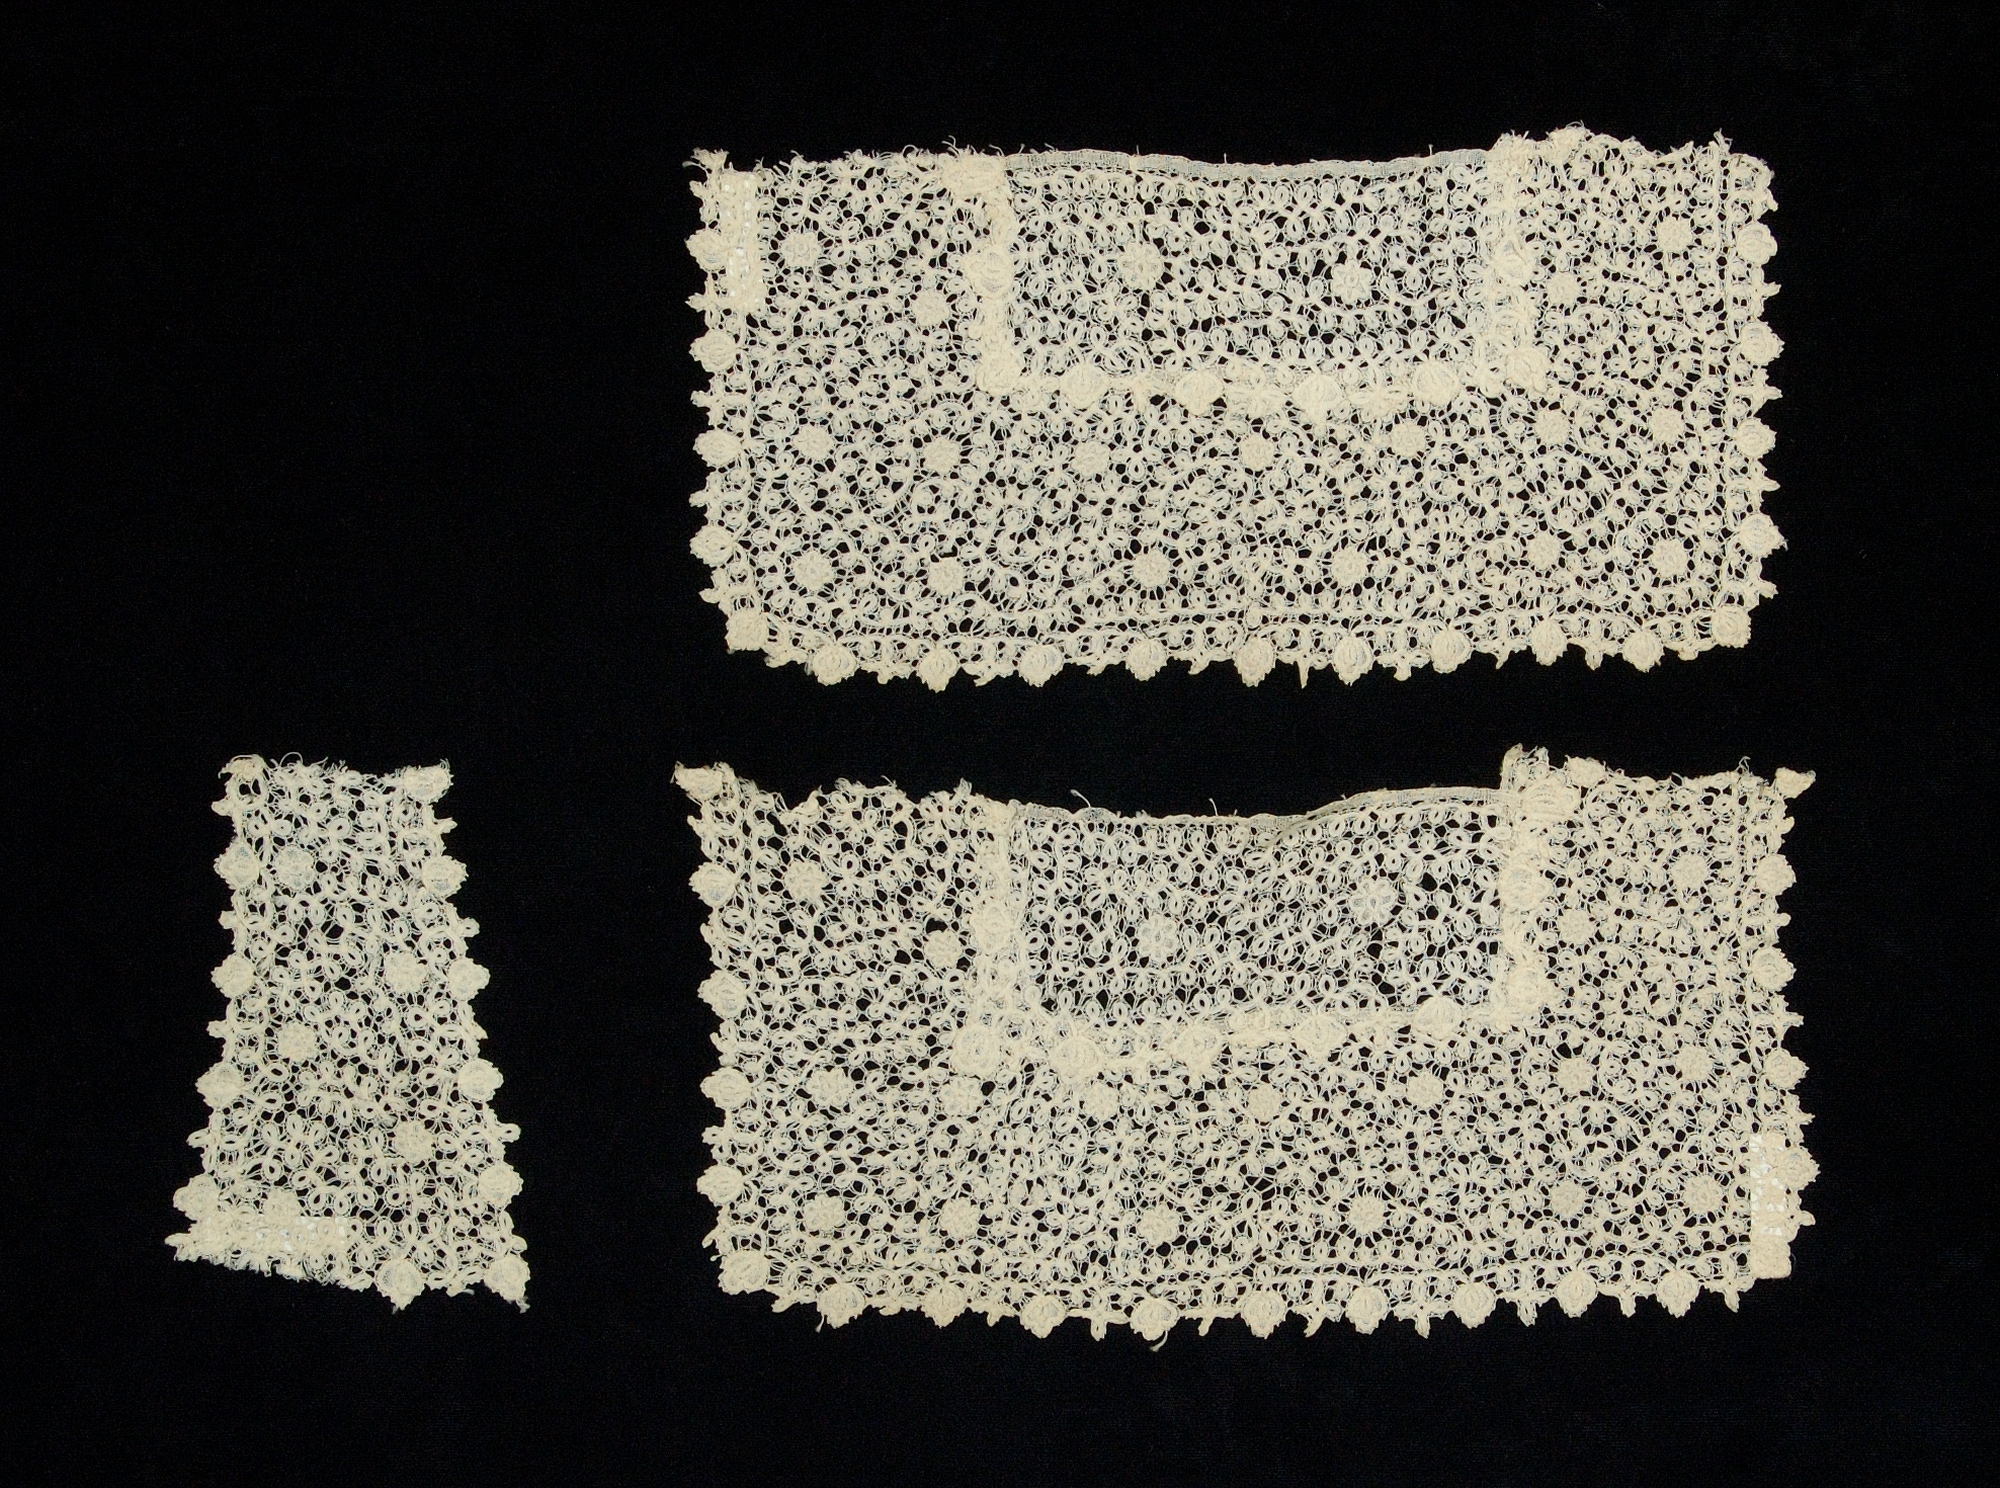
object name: cuff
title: Cuffs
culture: flemish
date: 1801-1825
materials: lace